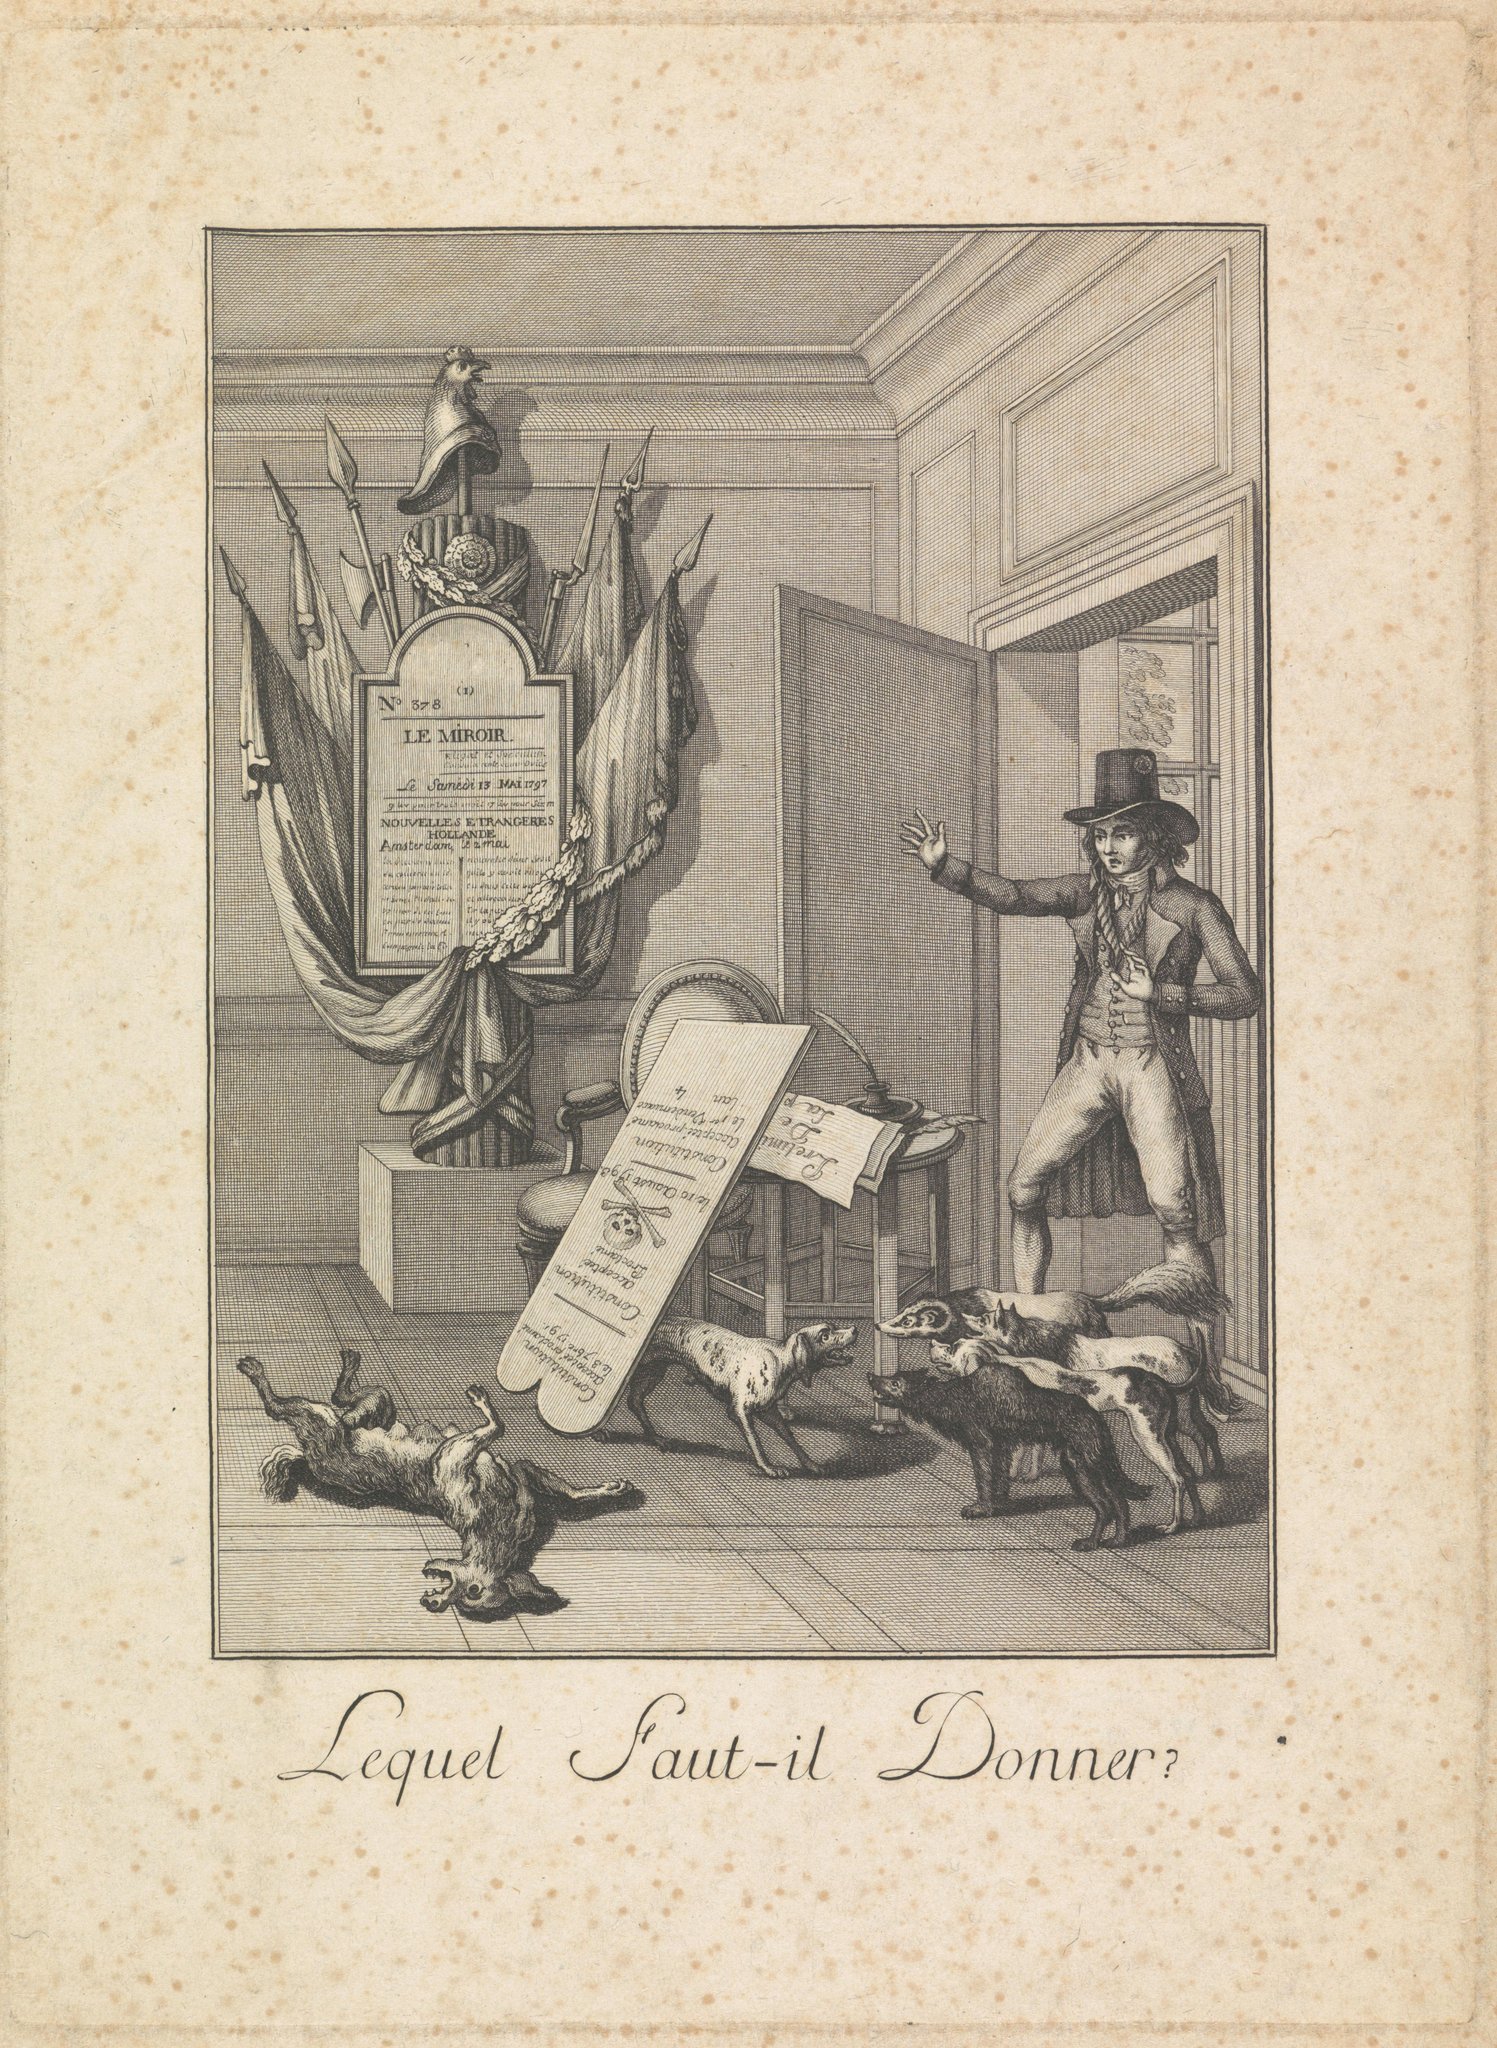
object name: cartoon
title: Spotprent op de Directoire, 1797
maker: Anonymous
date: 1797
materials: paper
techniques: engraving, etching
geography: france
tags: dog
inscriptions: collector's mark: Lugt 2228, collector's mark: Lugt 2488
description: Spotprent op de Franse revolutionaire bestuur Directoire, 1797. Een man komt een kamer binnen en vindt een groep honden die naar elkaar grommen met links een dode hond. Aan de wand een plakkaat 'Le Miroir' van 13 mei 1797, waarin melding wordt gemaakt van 'nouvelles etrangeres Hollande. Amsterdam, le 2 mai.'